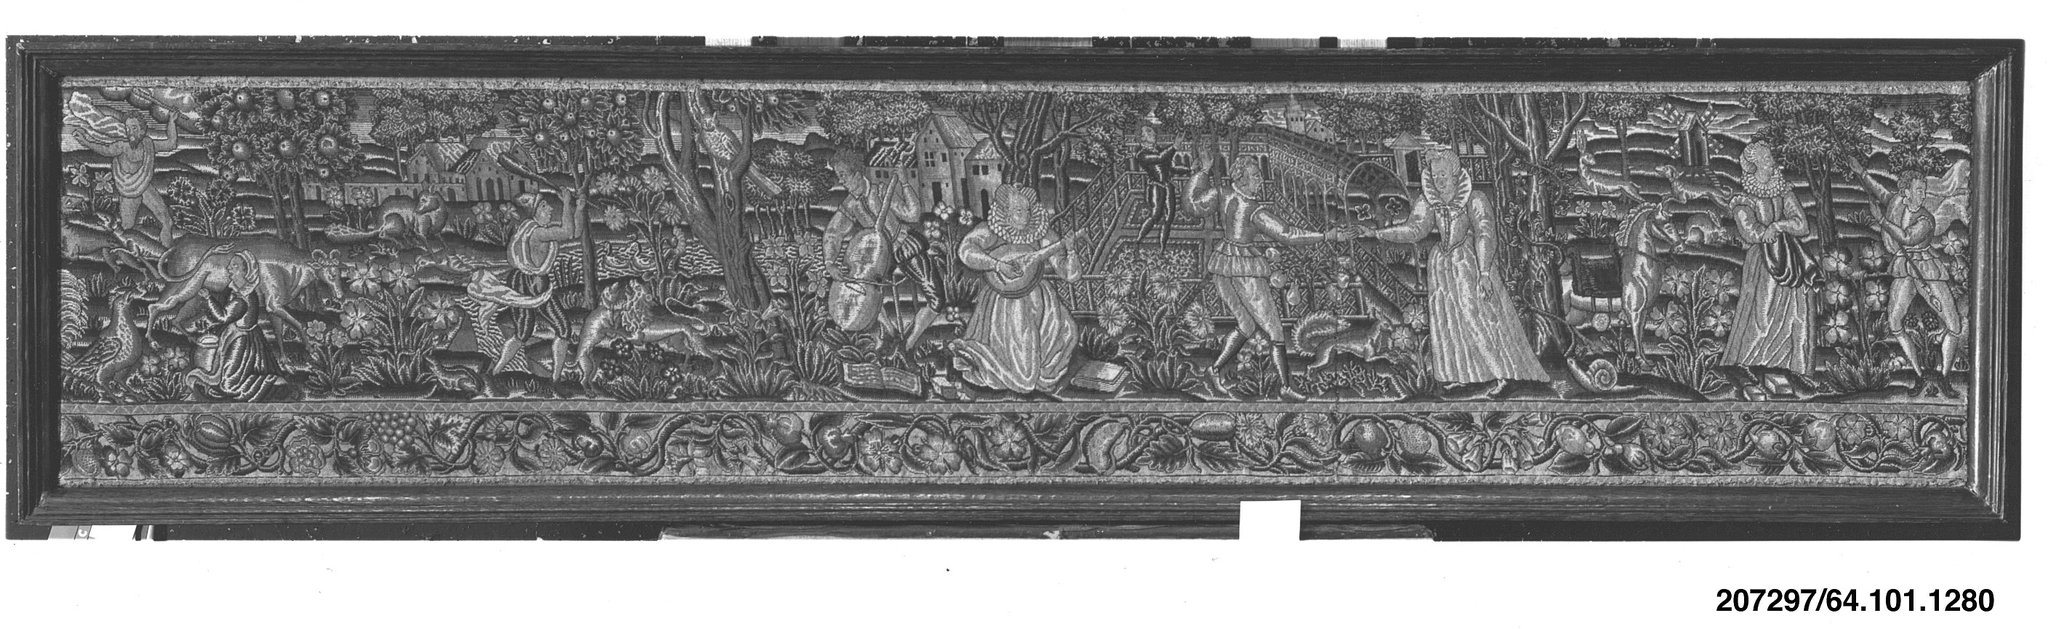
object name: valance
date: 1501-1600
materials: canvas, silk, wool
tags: musical instruments,men,women,cows,dogs,horses,musicians